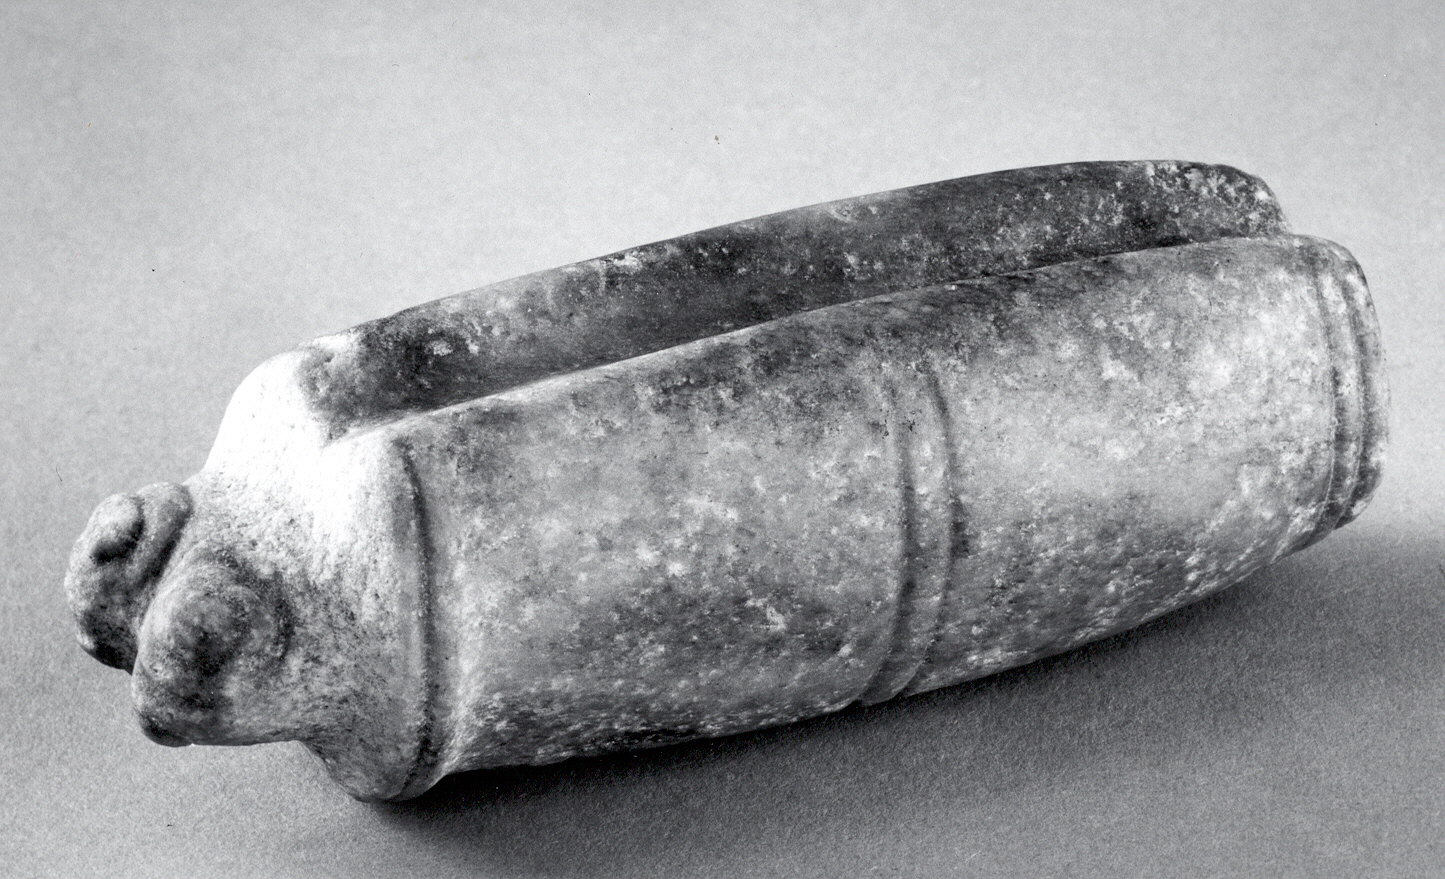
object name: arrow shaft straightener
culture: columbia river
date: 1301-1400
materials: granite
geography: united states